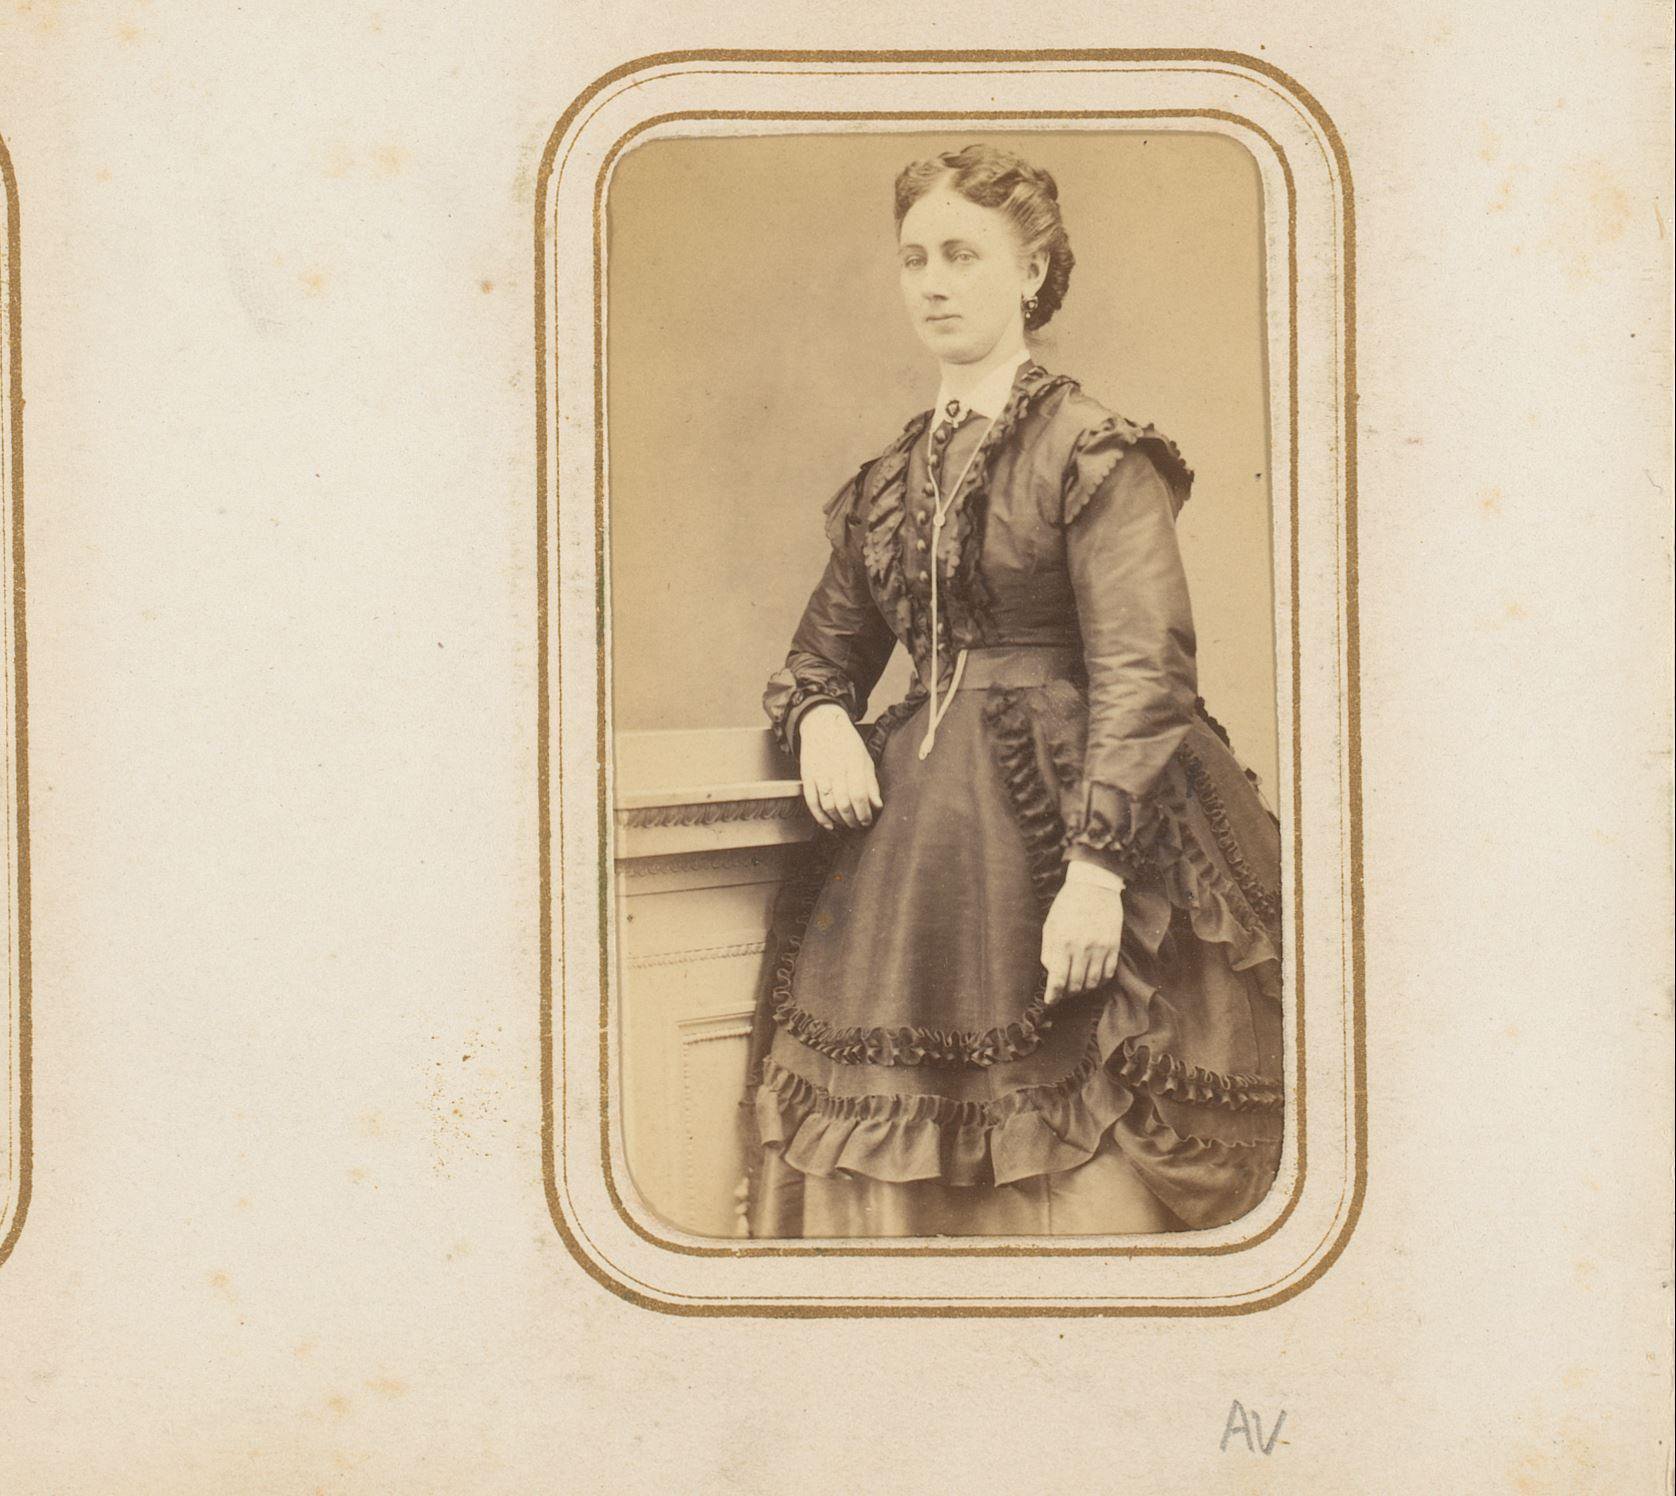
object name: album leaf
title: Portret van een jonge vrouw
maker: Anonymous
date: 1850-1880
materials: cardboard, photographic support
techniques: albumen print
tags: adolescent, young woman, maiden, historical persons - bb - woman